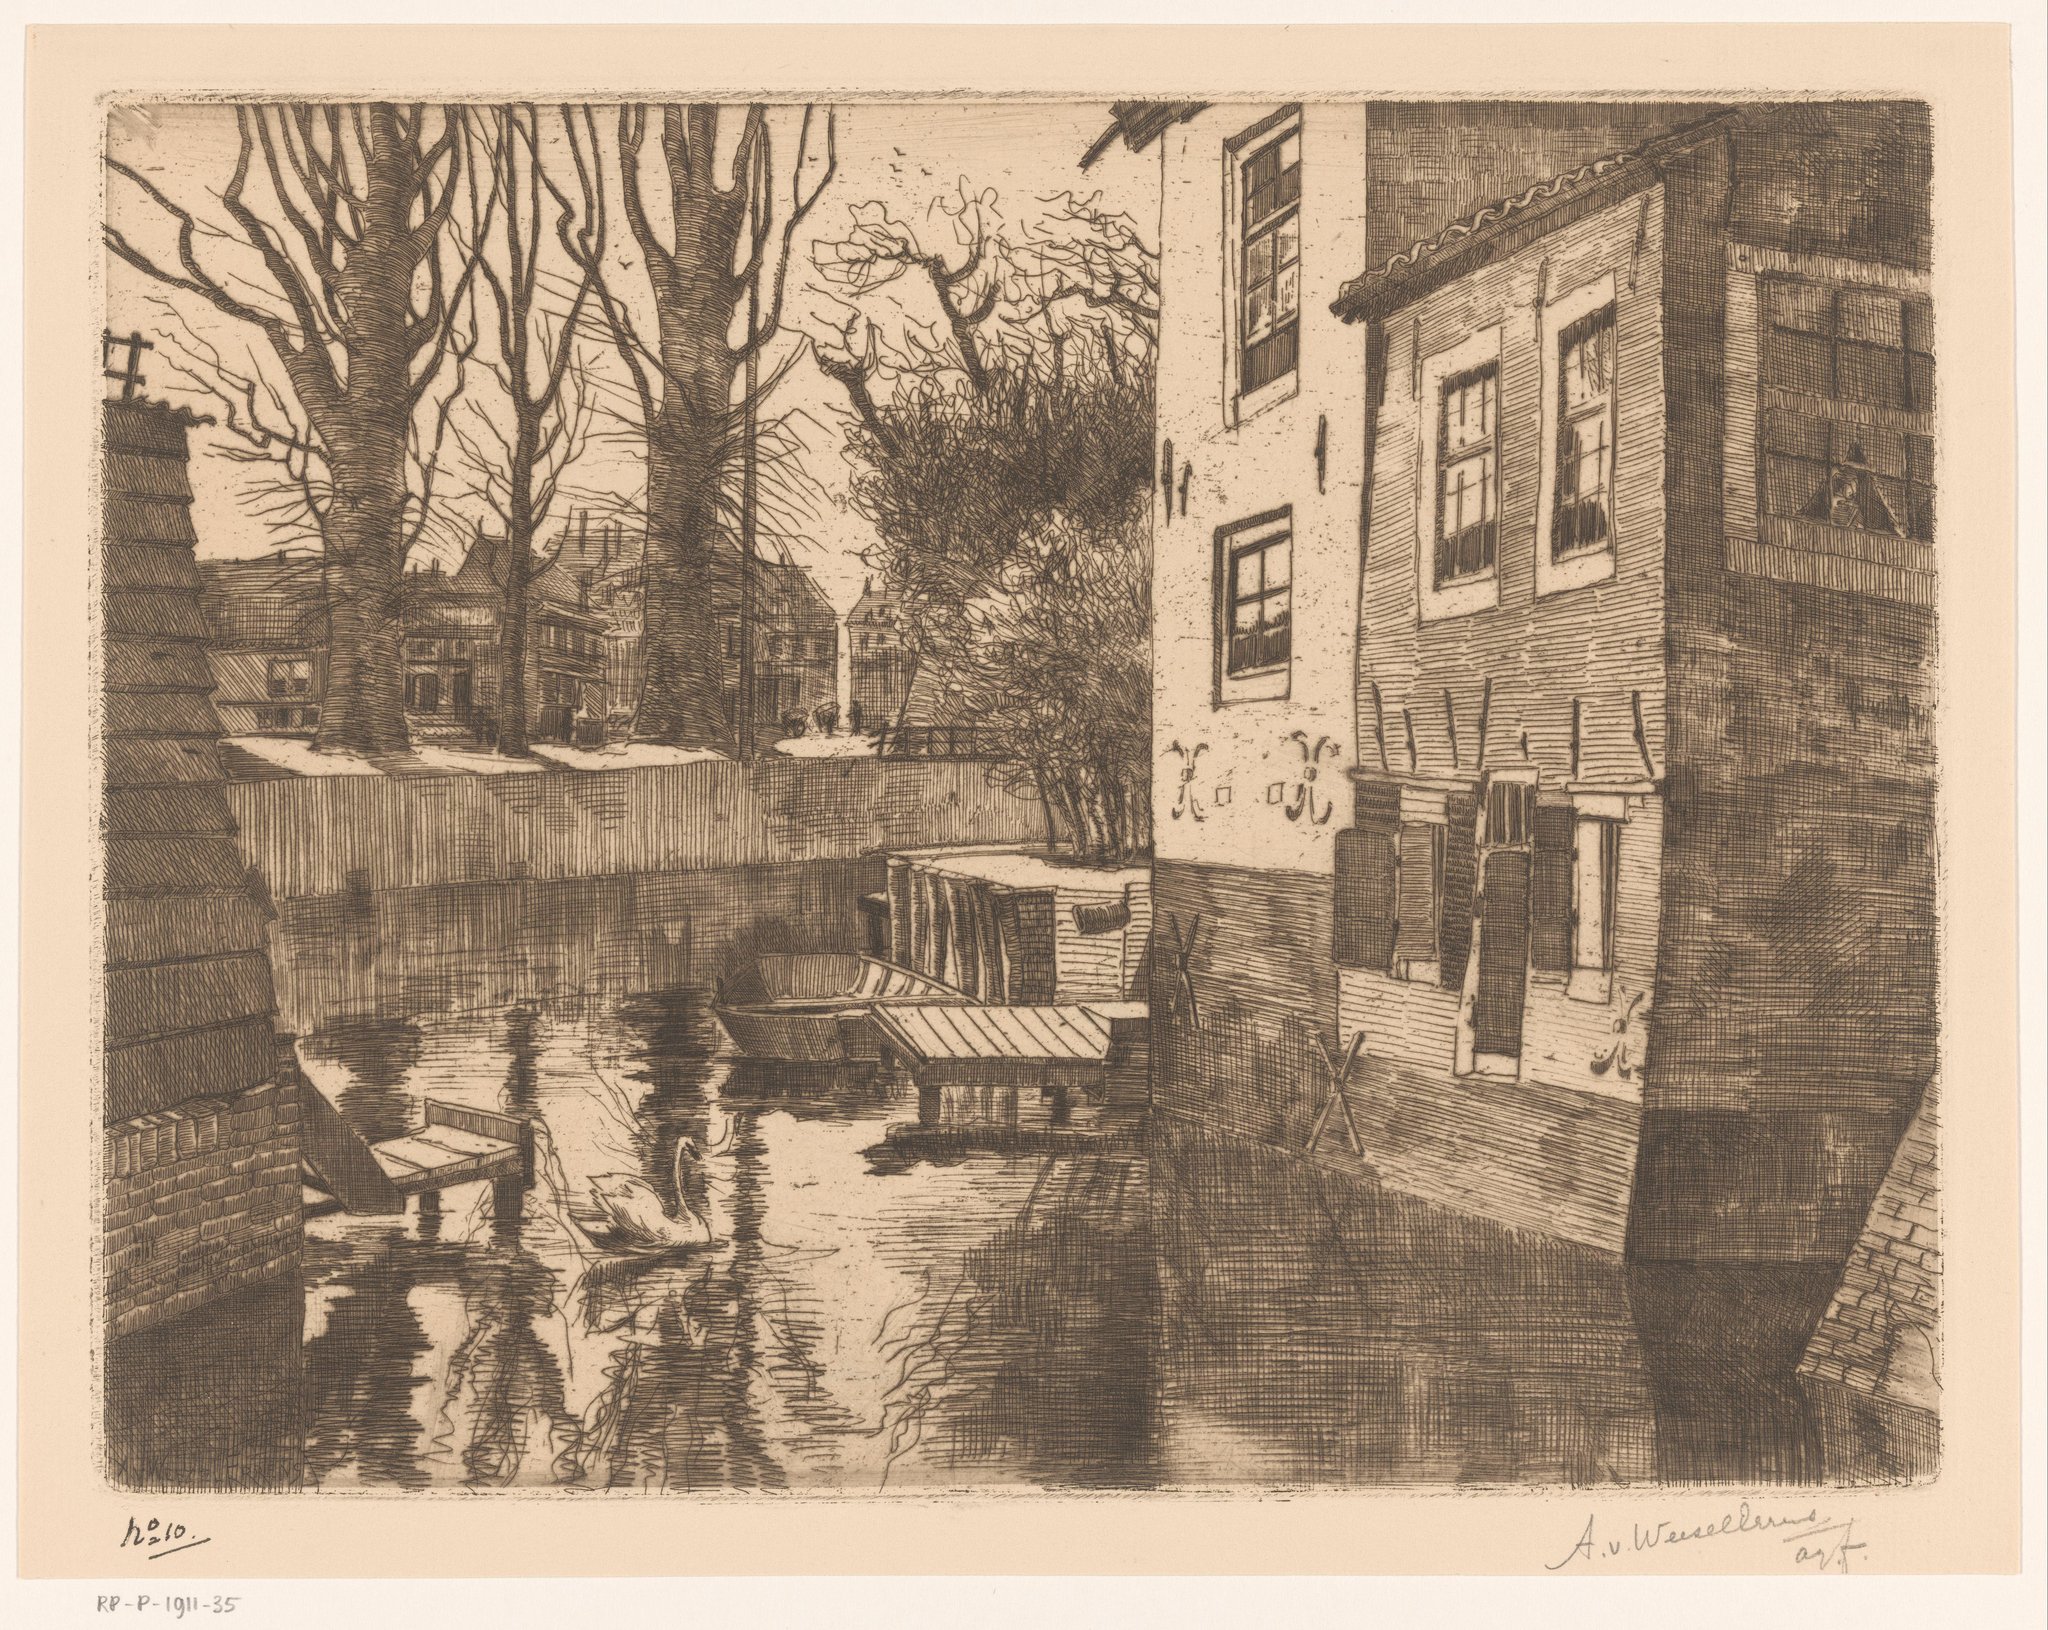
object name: print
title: Zuidsingel te Amersfoort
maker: adolphe p.h j. van weezel errens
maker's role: print maker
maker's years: 1866-1939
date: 1876-1911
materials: paper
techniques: etching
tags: canals, waters (in city)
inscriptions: collector's mark: Lugt 2228, inscription: ‘No. 10’